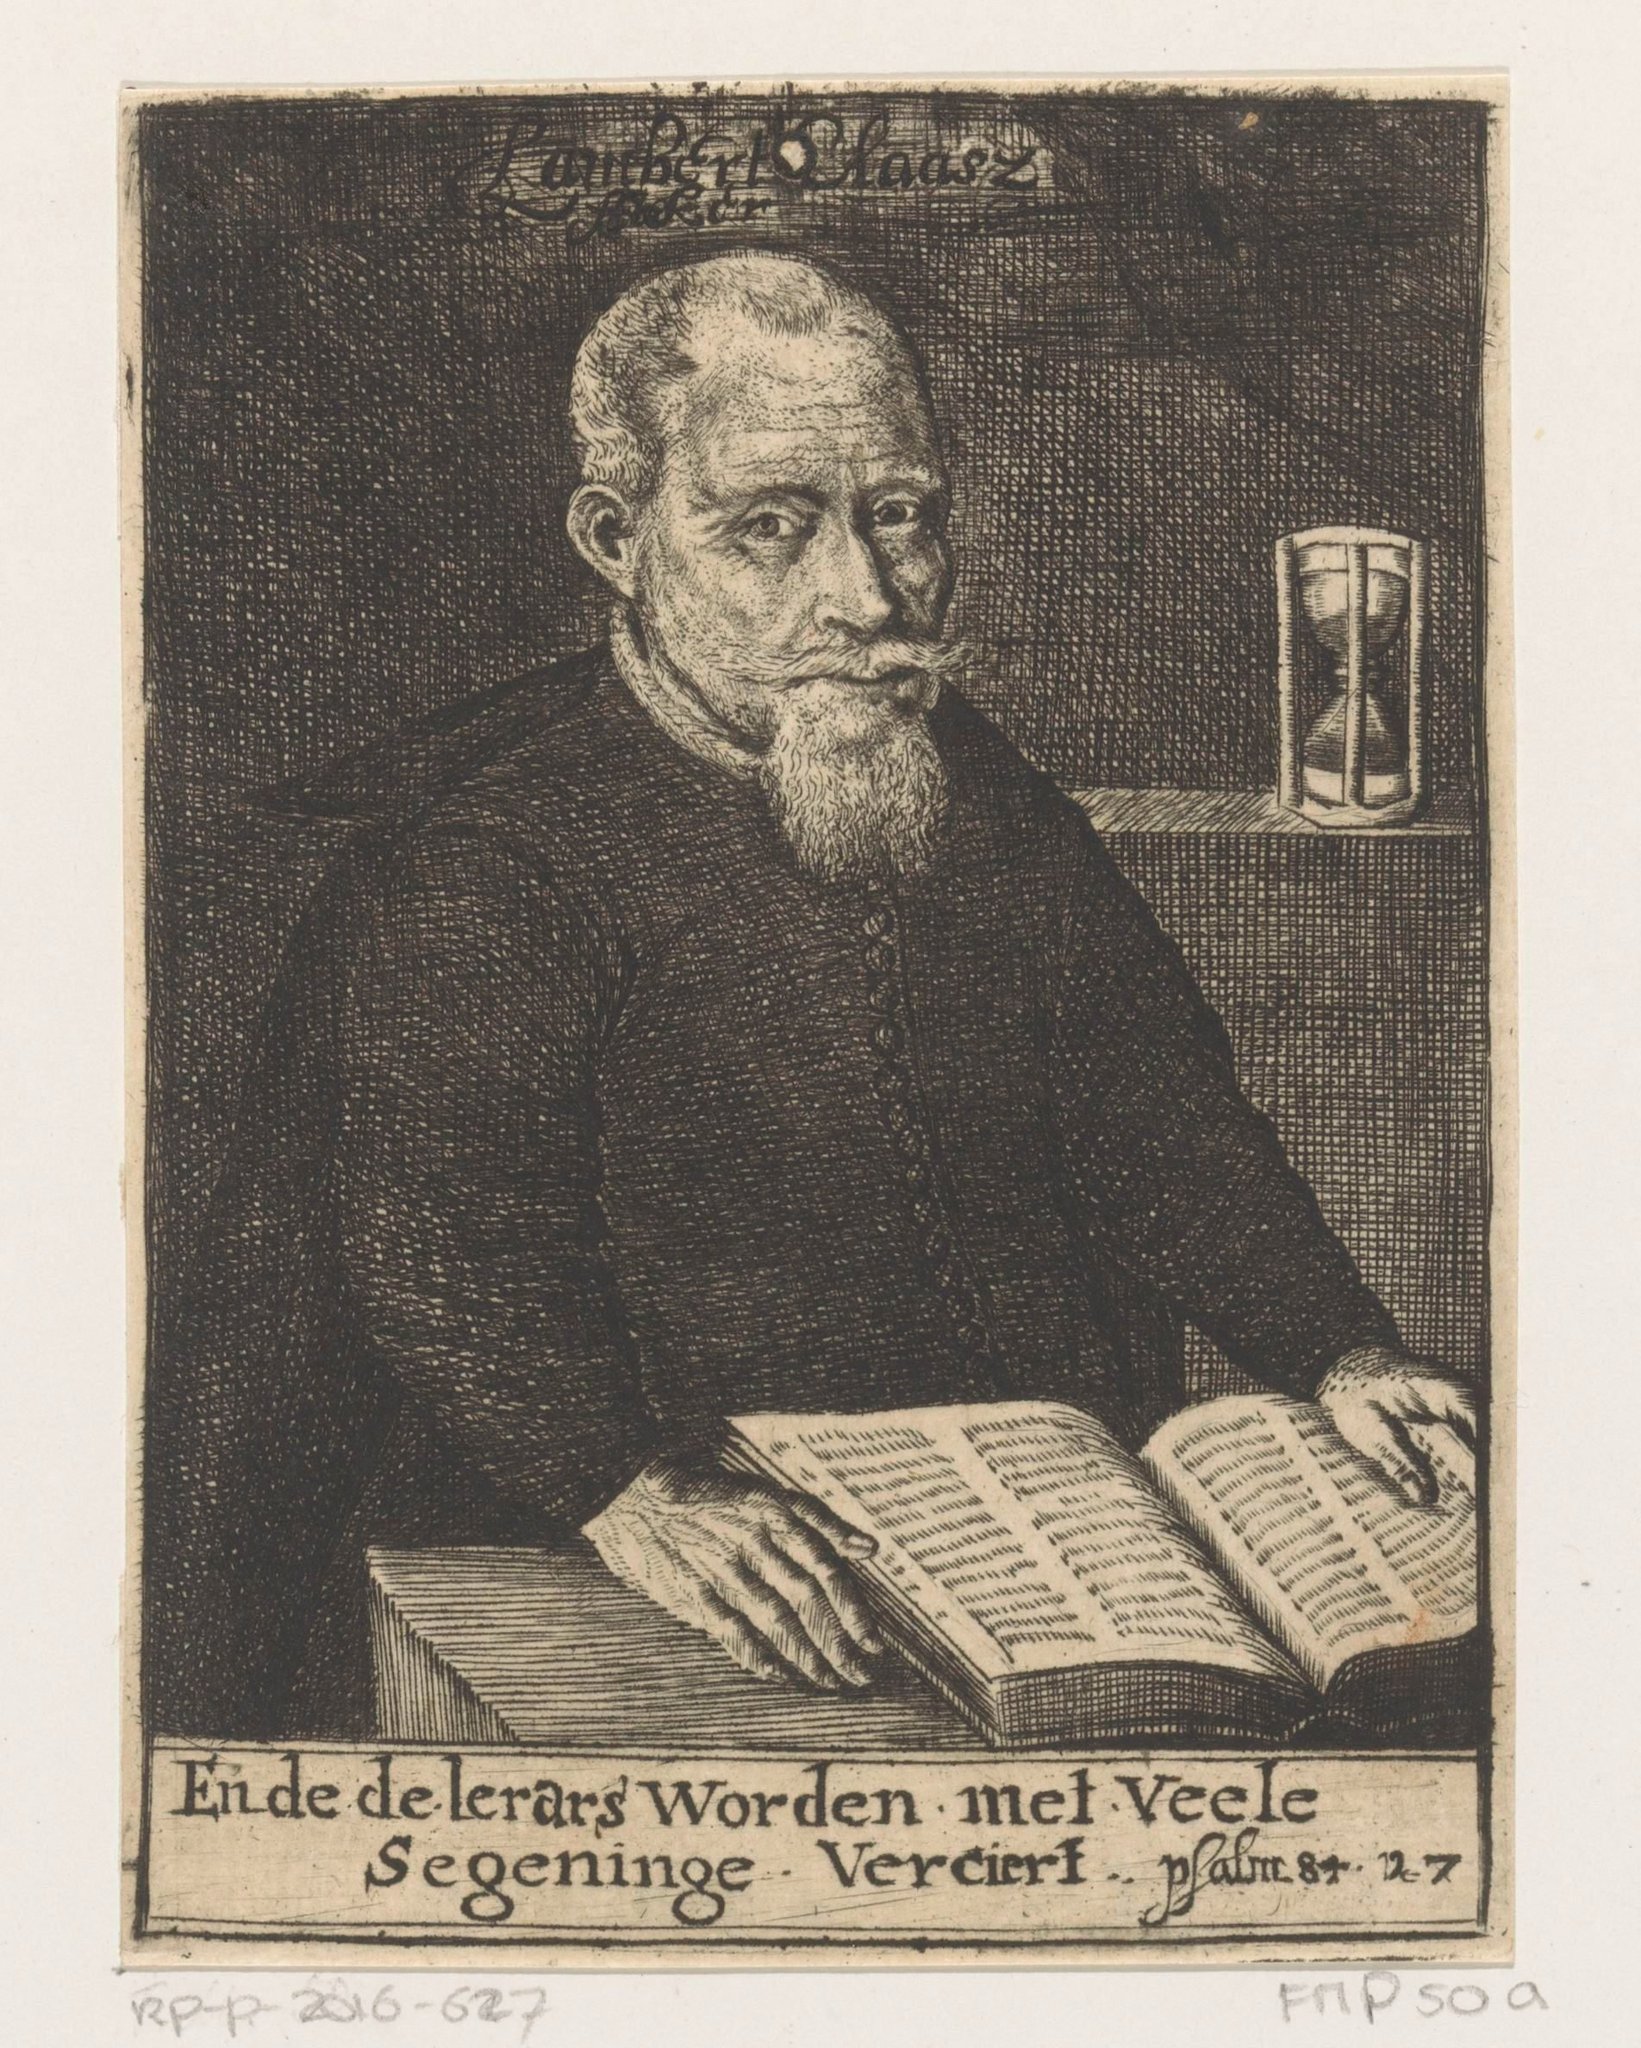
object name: print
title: Portret van Lambert Klaasz. Aker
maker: Anonymous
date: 1700-1799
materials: paper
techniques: engraving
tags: predikant, lambert klaasz. aker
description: Portret van Lambert Klaasz. Aker. Hij zit in een stoel aan een tafel met daarop een boek. Op de achtergrond staat een zandloper. In de bovenmarge zijn naam. In een kader twee regels Nederlandse tekst.